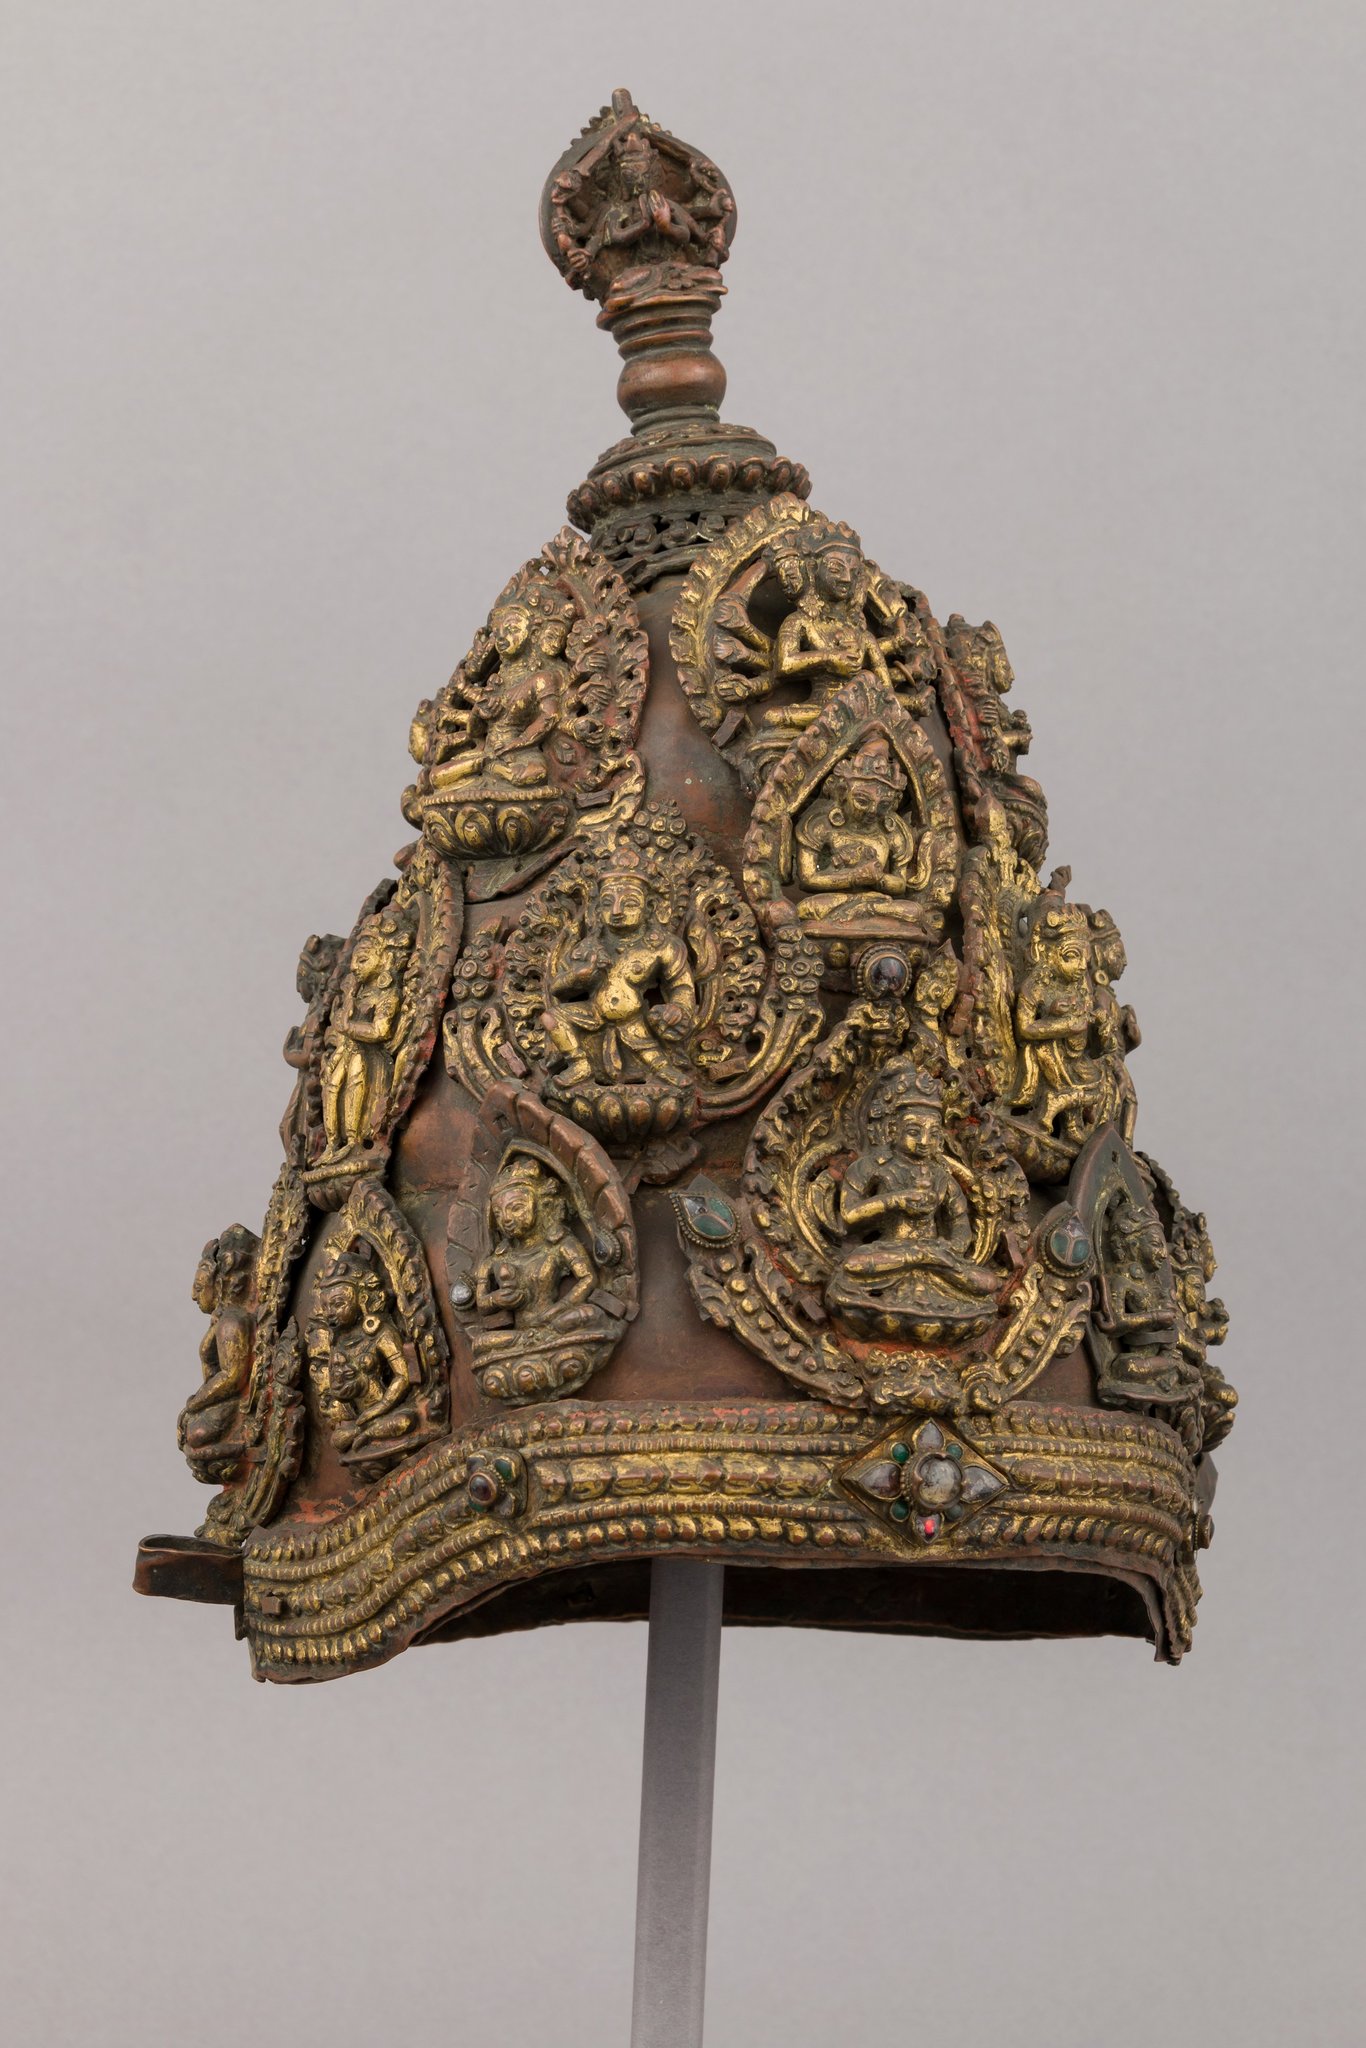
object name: vajracarya priest's crown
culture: nepalese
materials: copper, gold, stone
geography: tibet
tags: buddhism,crowns